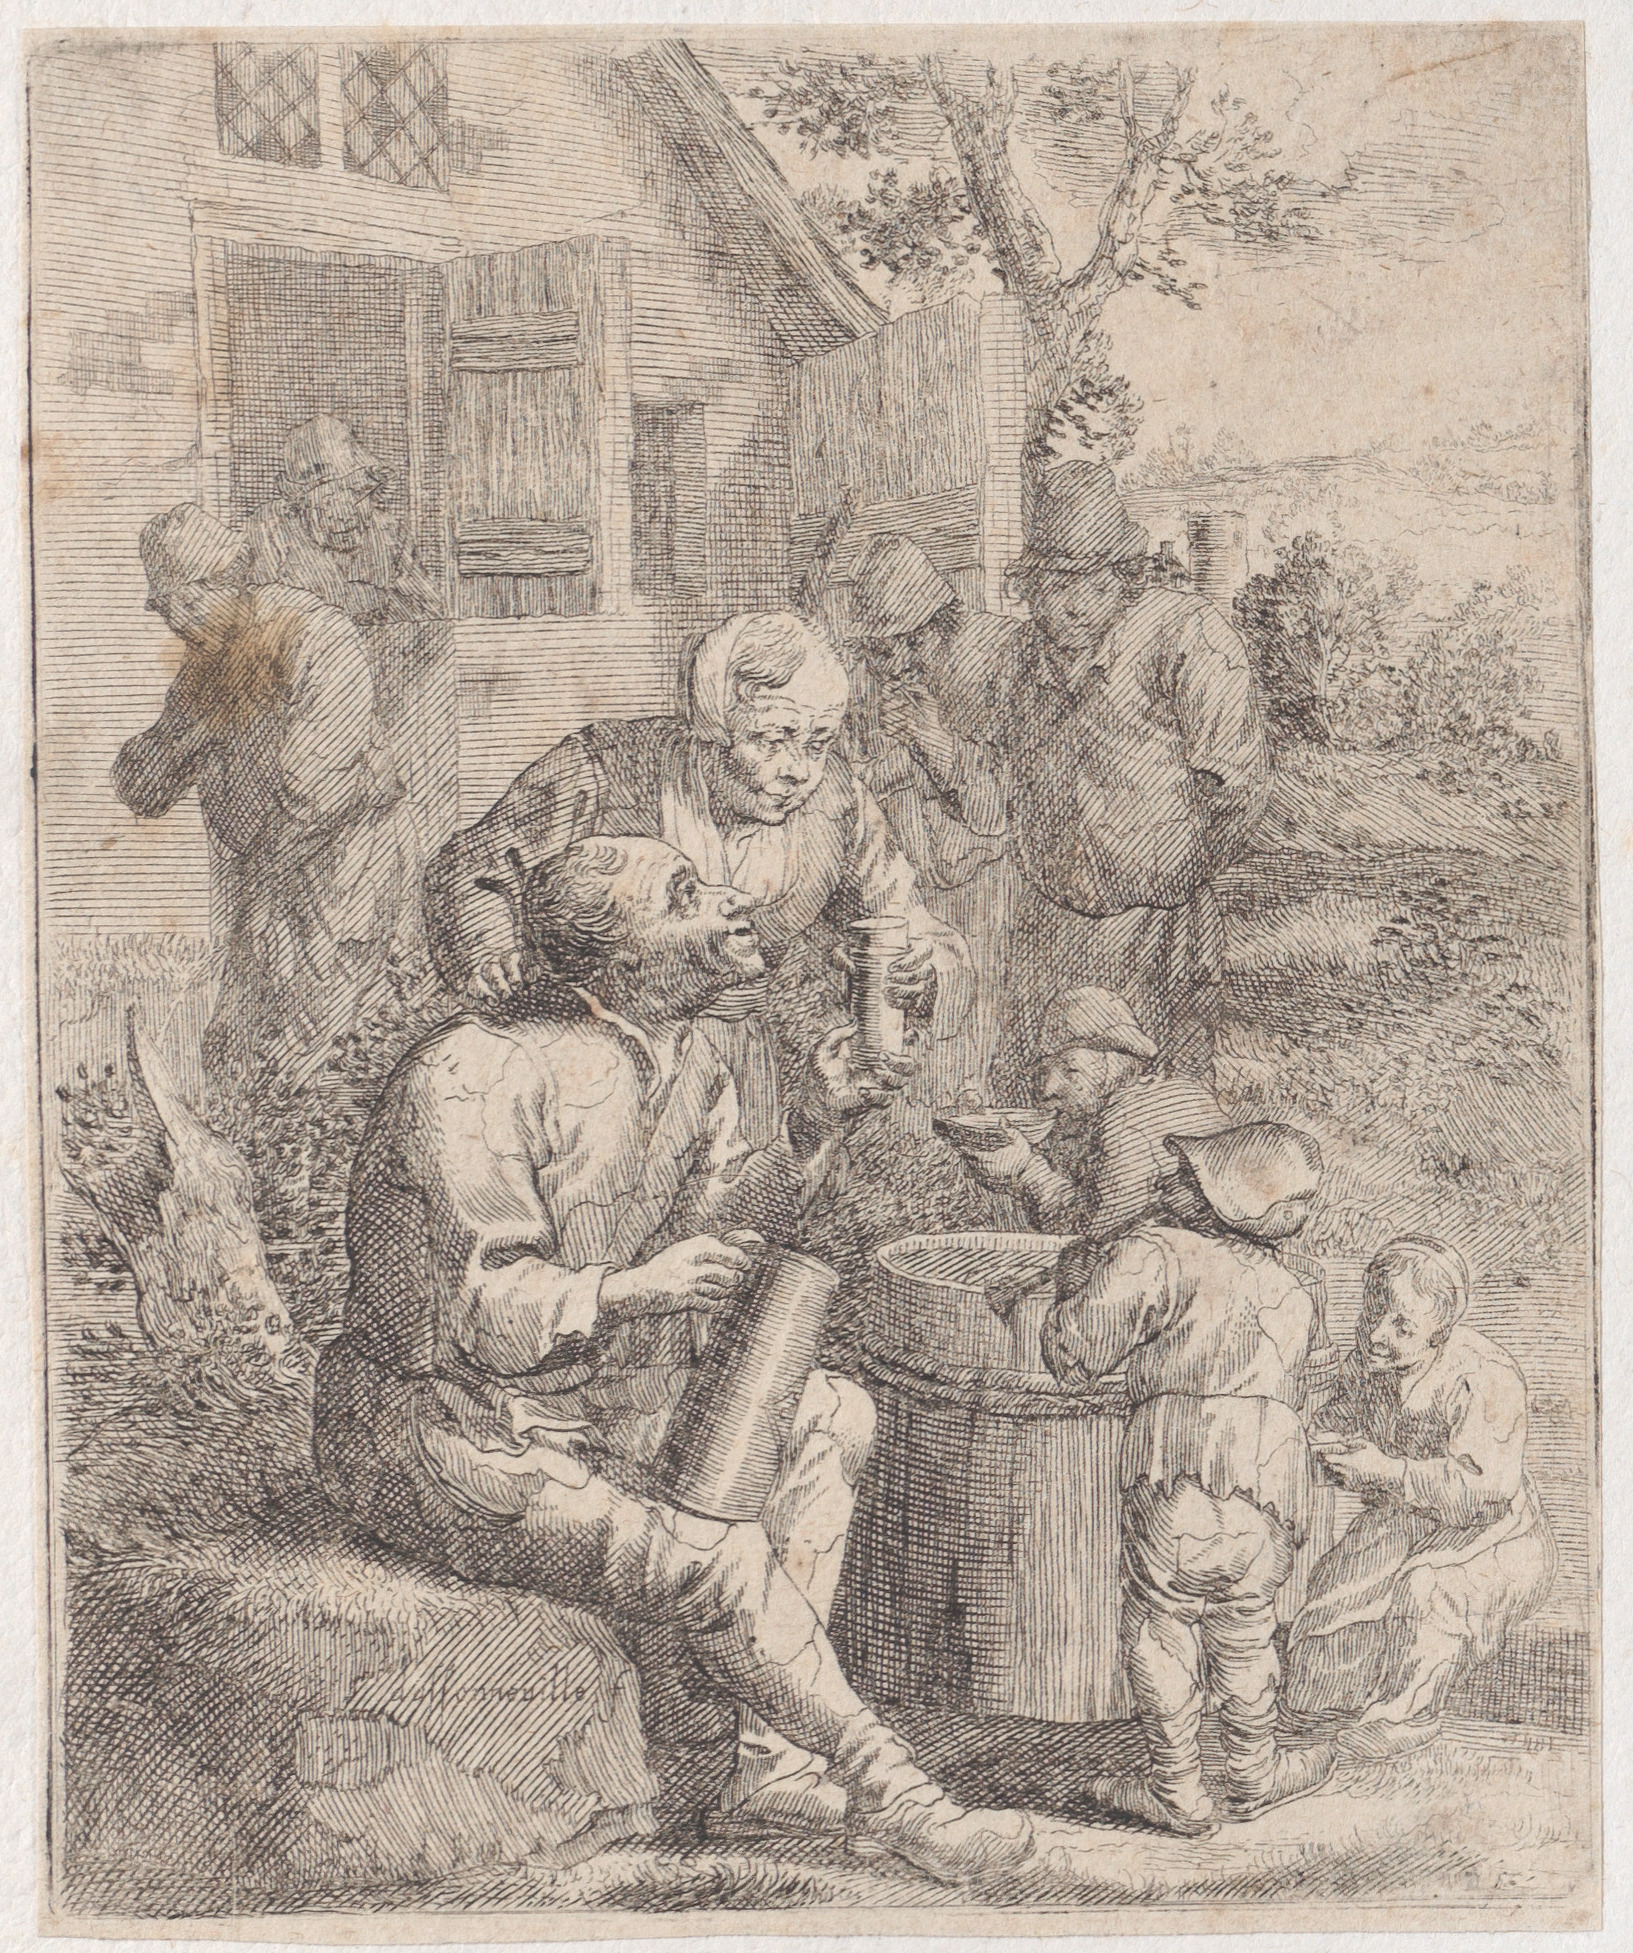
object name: print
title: Nine peasants outside of a rustic house, with a seated man holding a pint and giving a glass to a woman in the foreground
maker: jacques dassonville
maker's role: artist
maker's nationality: french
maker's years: 1614-1675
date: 1640-1670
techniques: etching